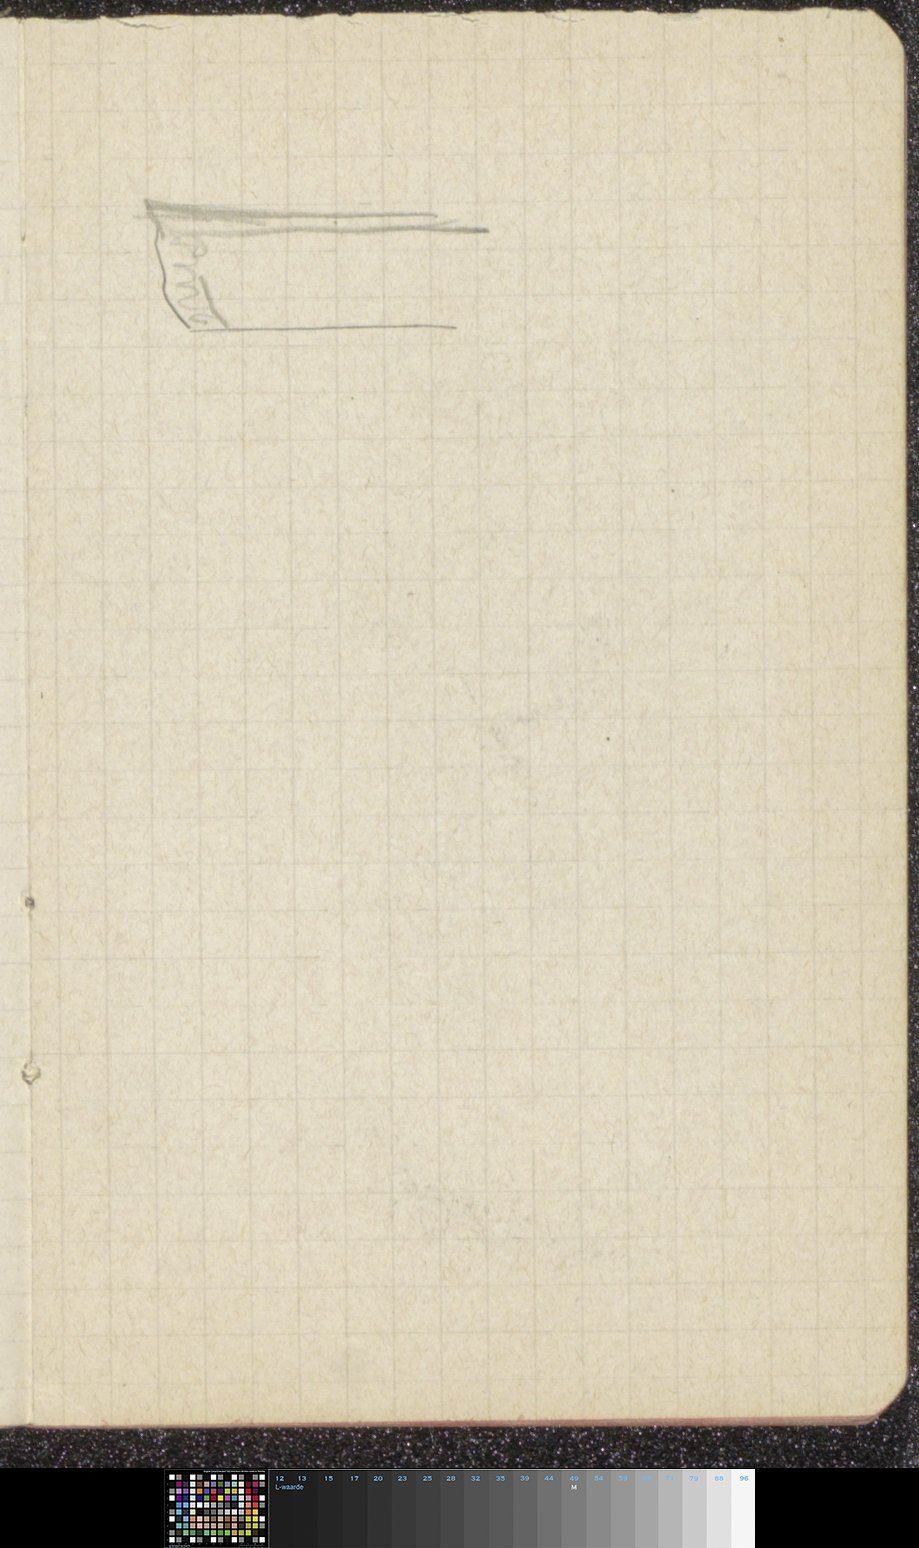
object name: sketchbook leaf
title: Studie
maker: marius bauer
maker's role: draughtsman, print maker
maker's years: 1867-1932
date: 1902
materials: pencil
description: Pagina 7 uit een schetsboek met 23 bladen.